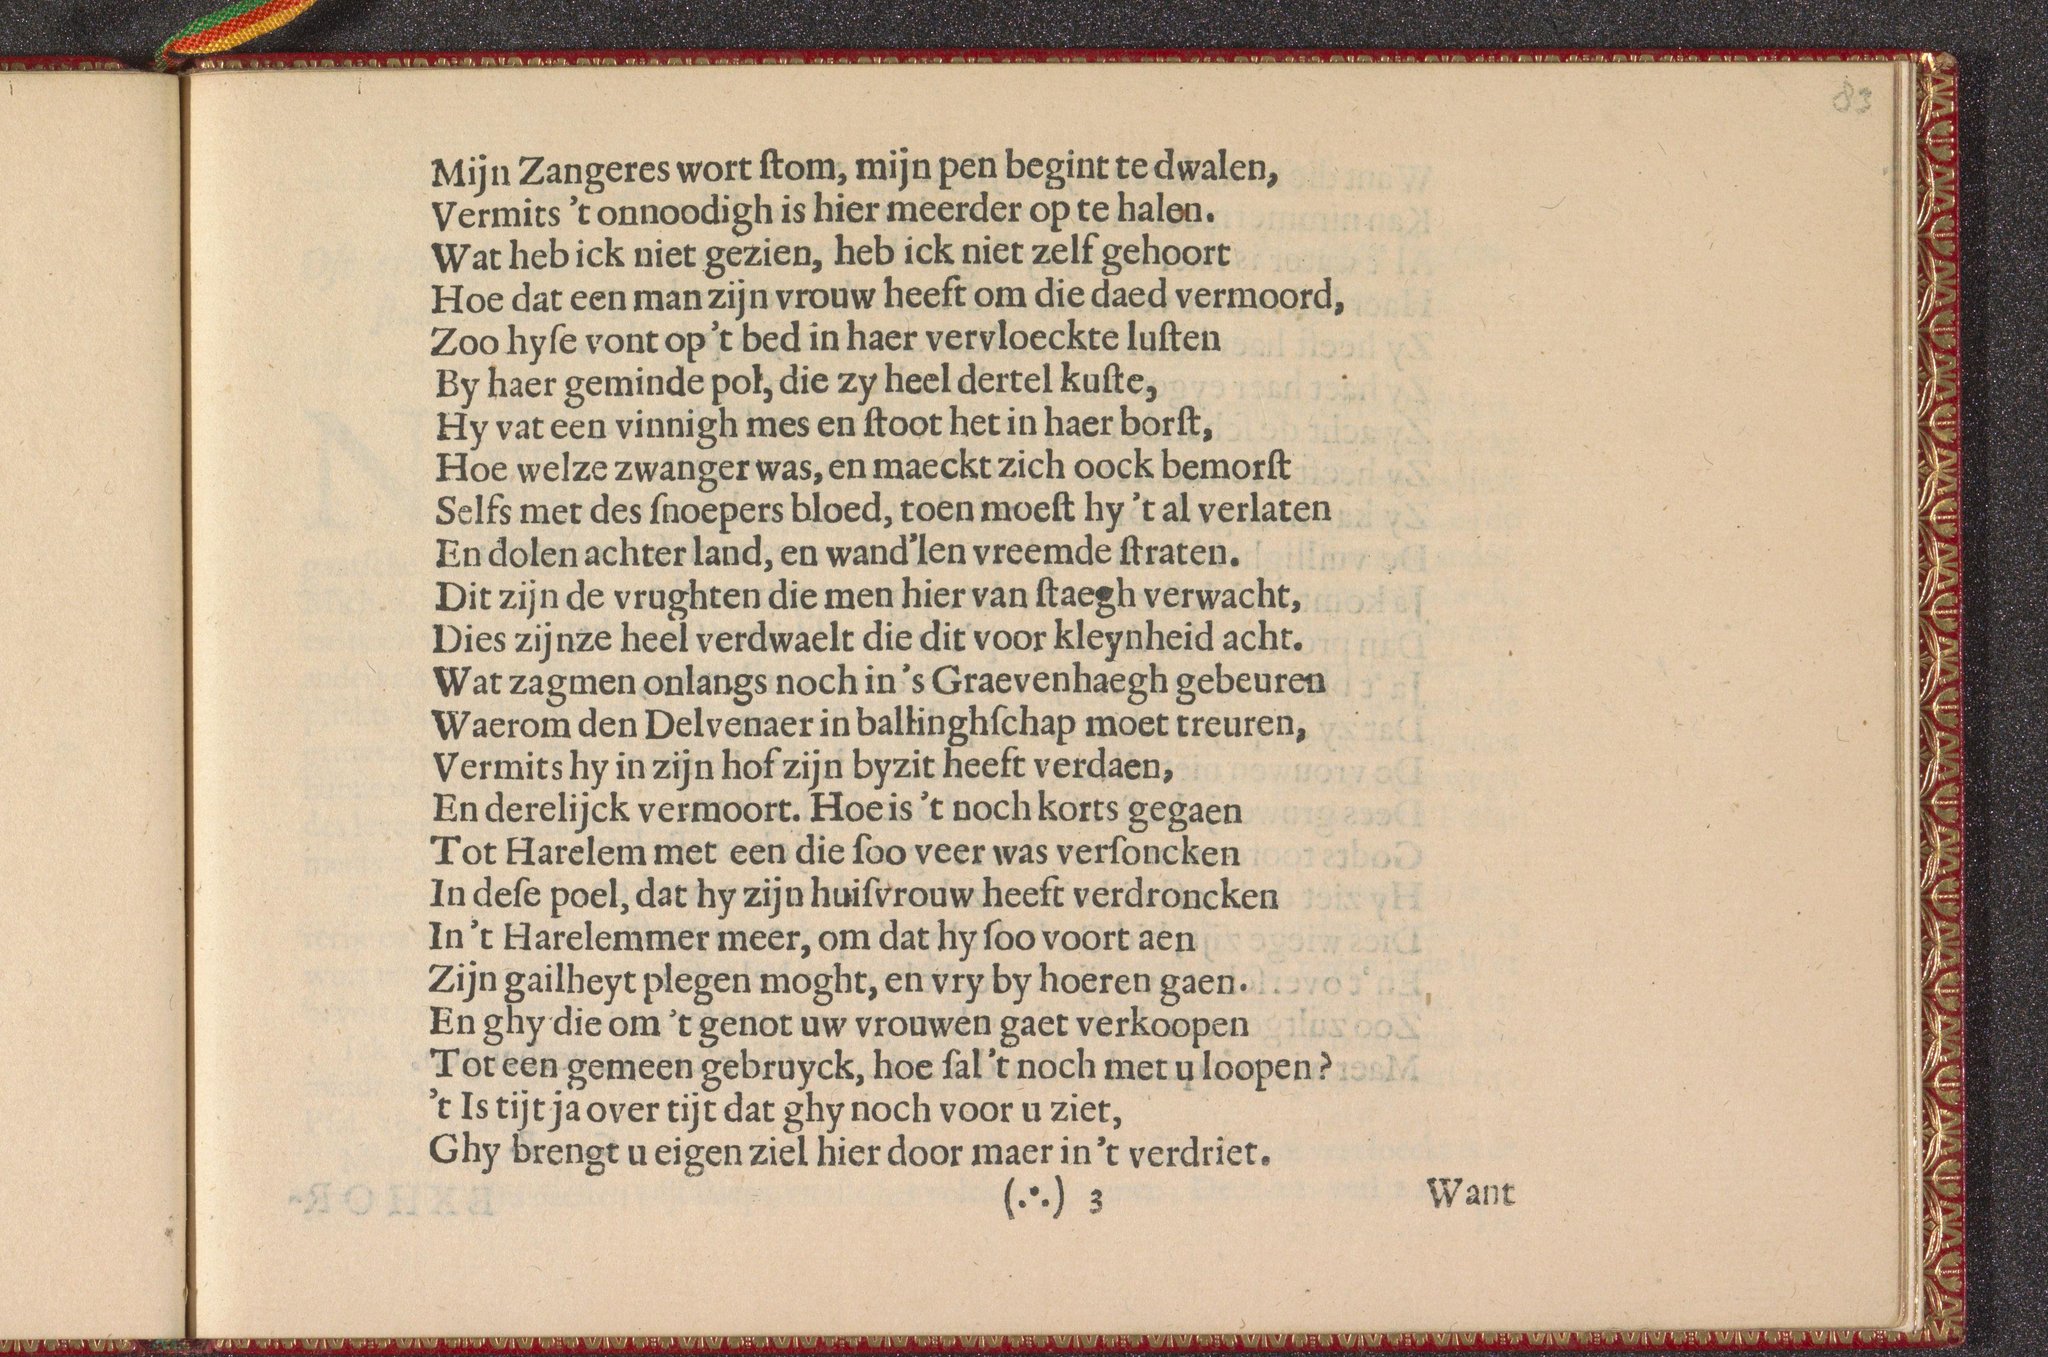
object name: album leaf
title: Vermaningen, pagina 5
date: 1641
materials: paper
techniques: letterpress printing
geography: amsterdam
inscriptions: date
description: Vermaningen op zes pagina's: pagina 5. Het blad maakt deel uit van een album.